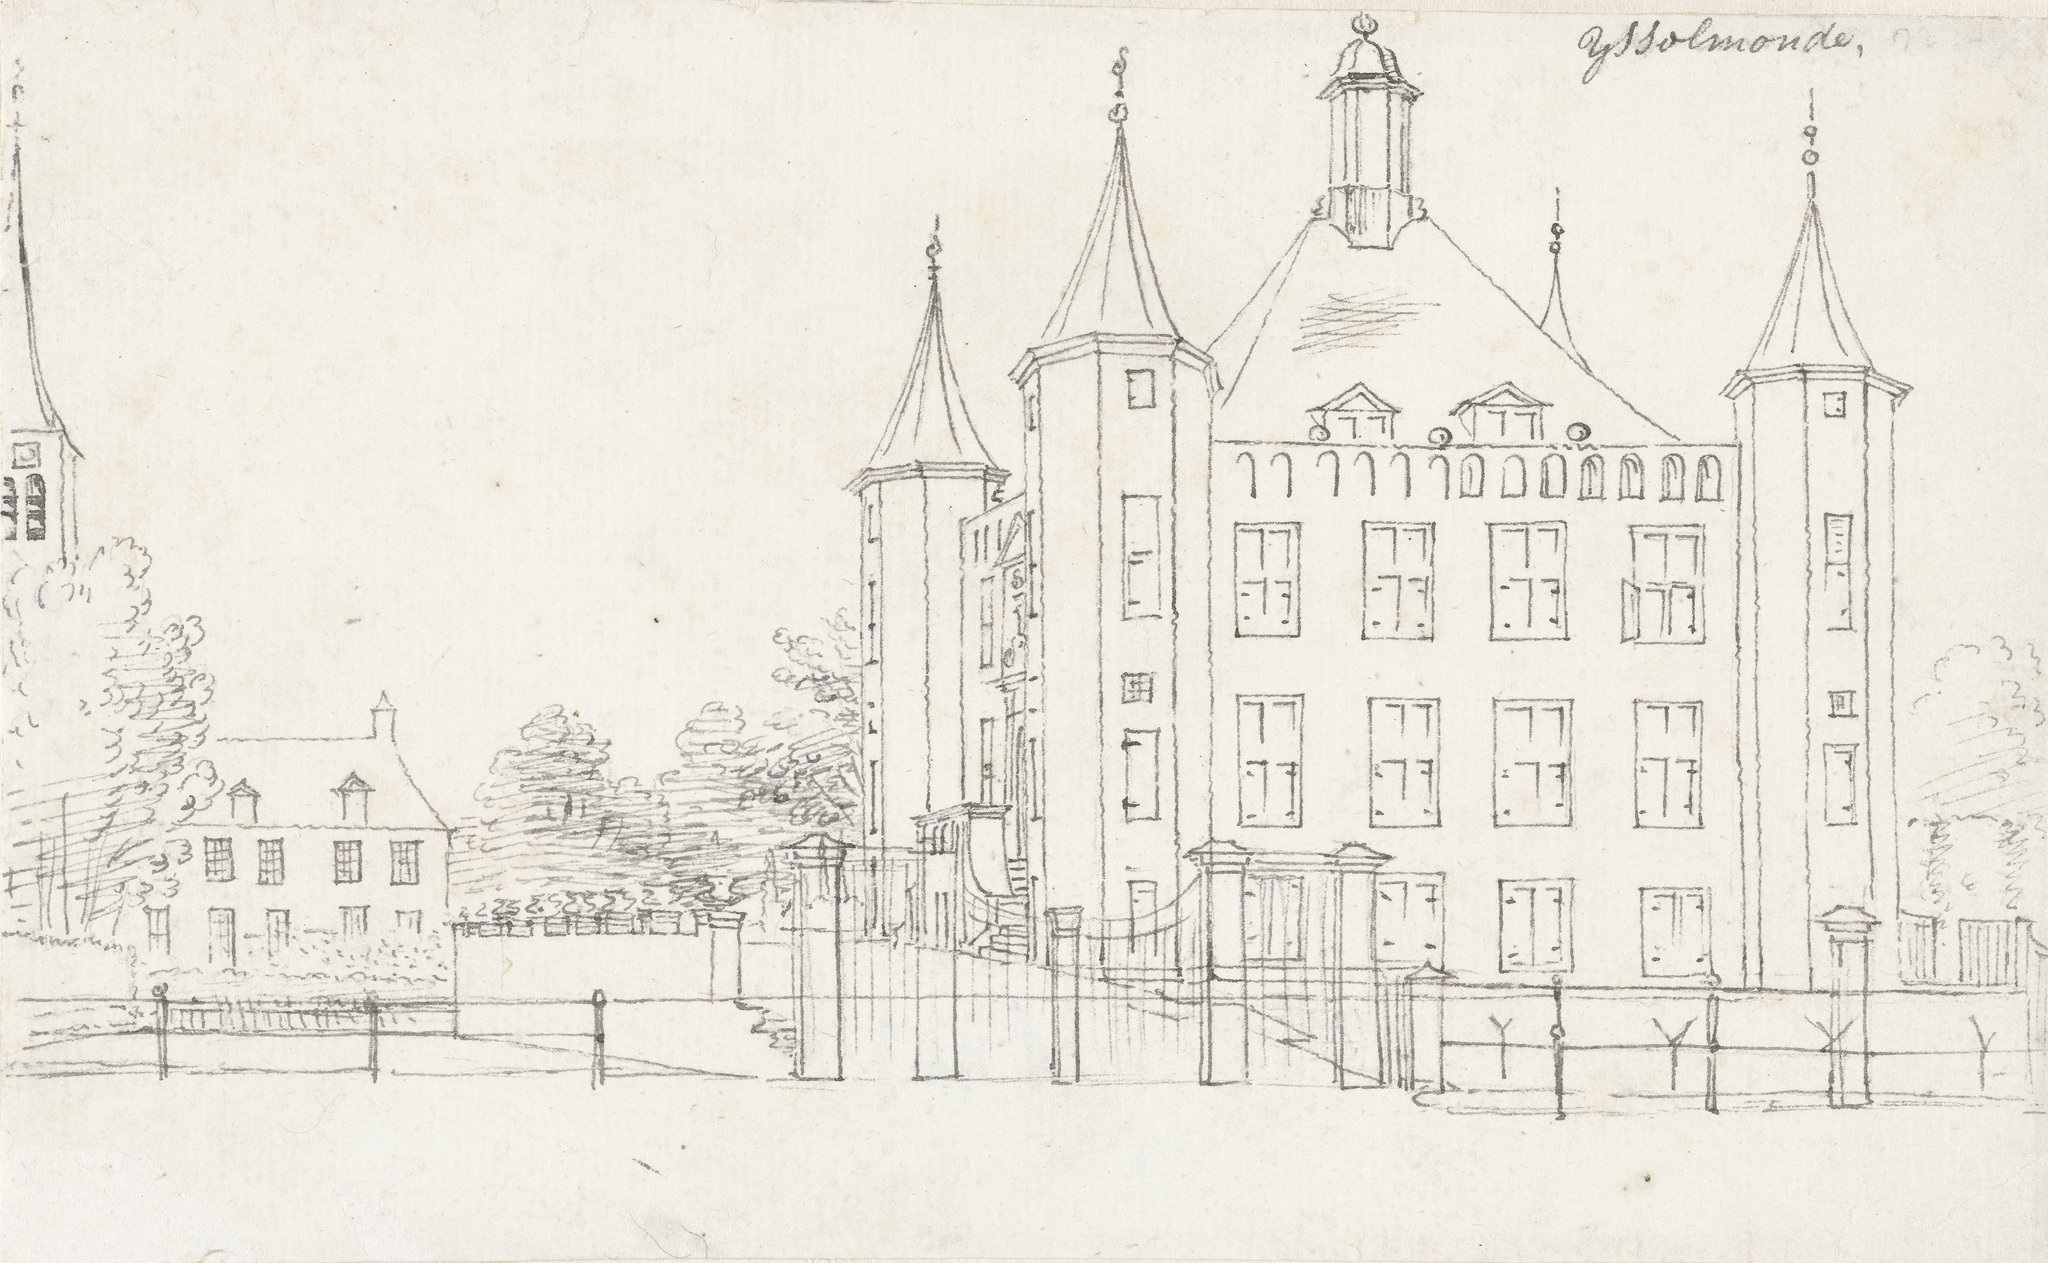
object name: drawing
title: Het kasteel te IJsselmonde met links de kerktoren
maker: cornelis pronk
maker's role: draughtsman, painter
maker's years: 1691-1759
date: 1720-1740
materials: ink, paper, pencil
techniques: pen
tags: prospect of village, silhouette of village, castle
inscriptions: inscription: ‘IJsselmonde’